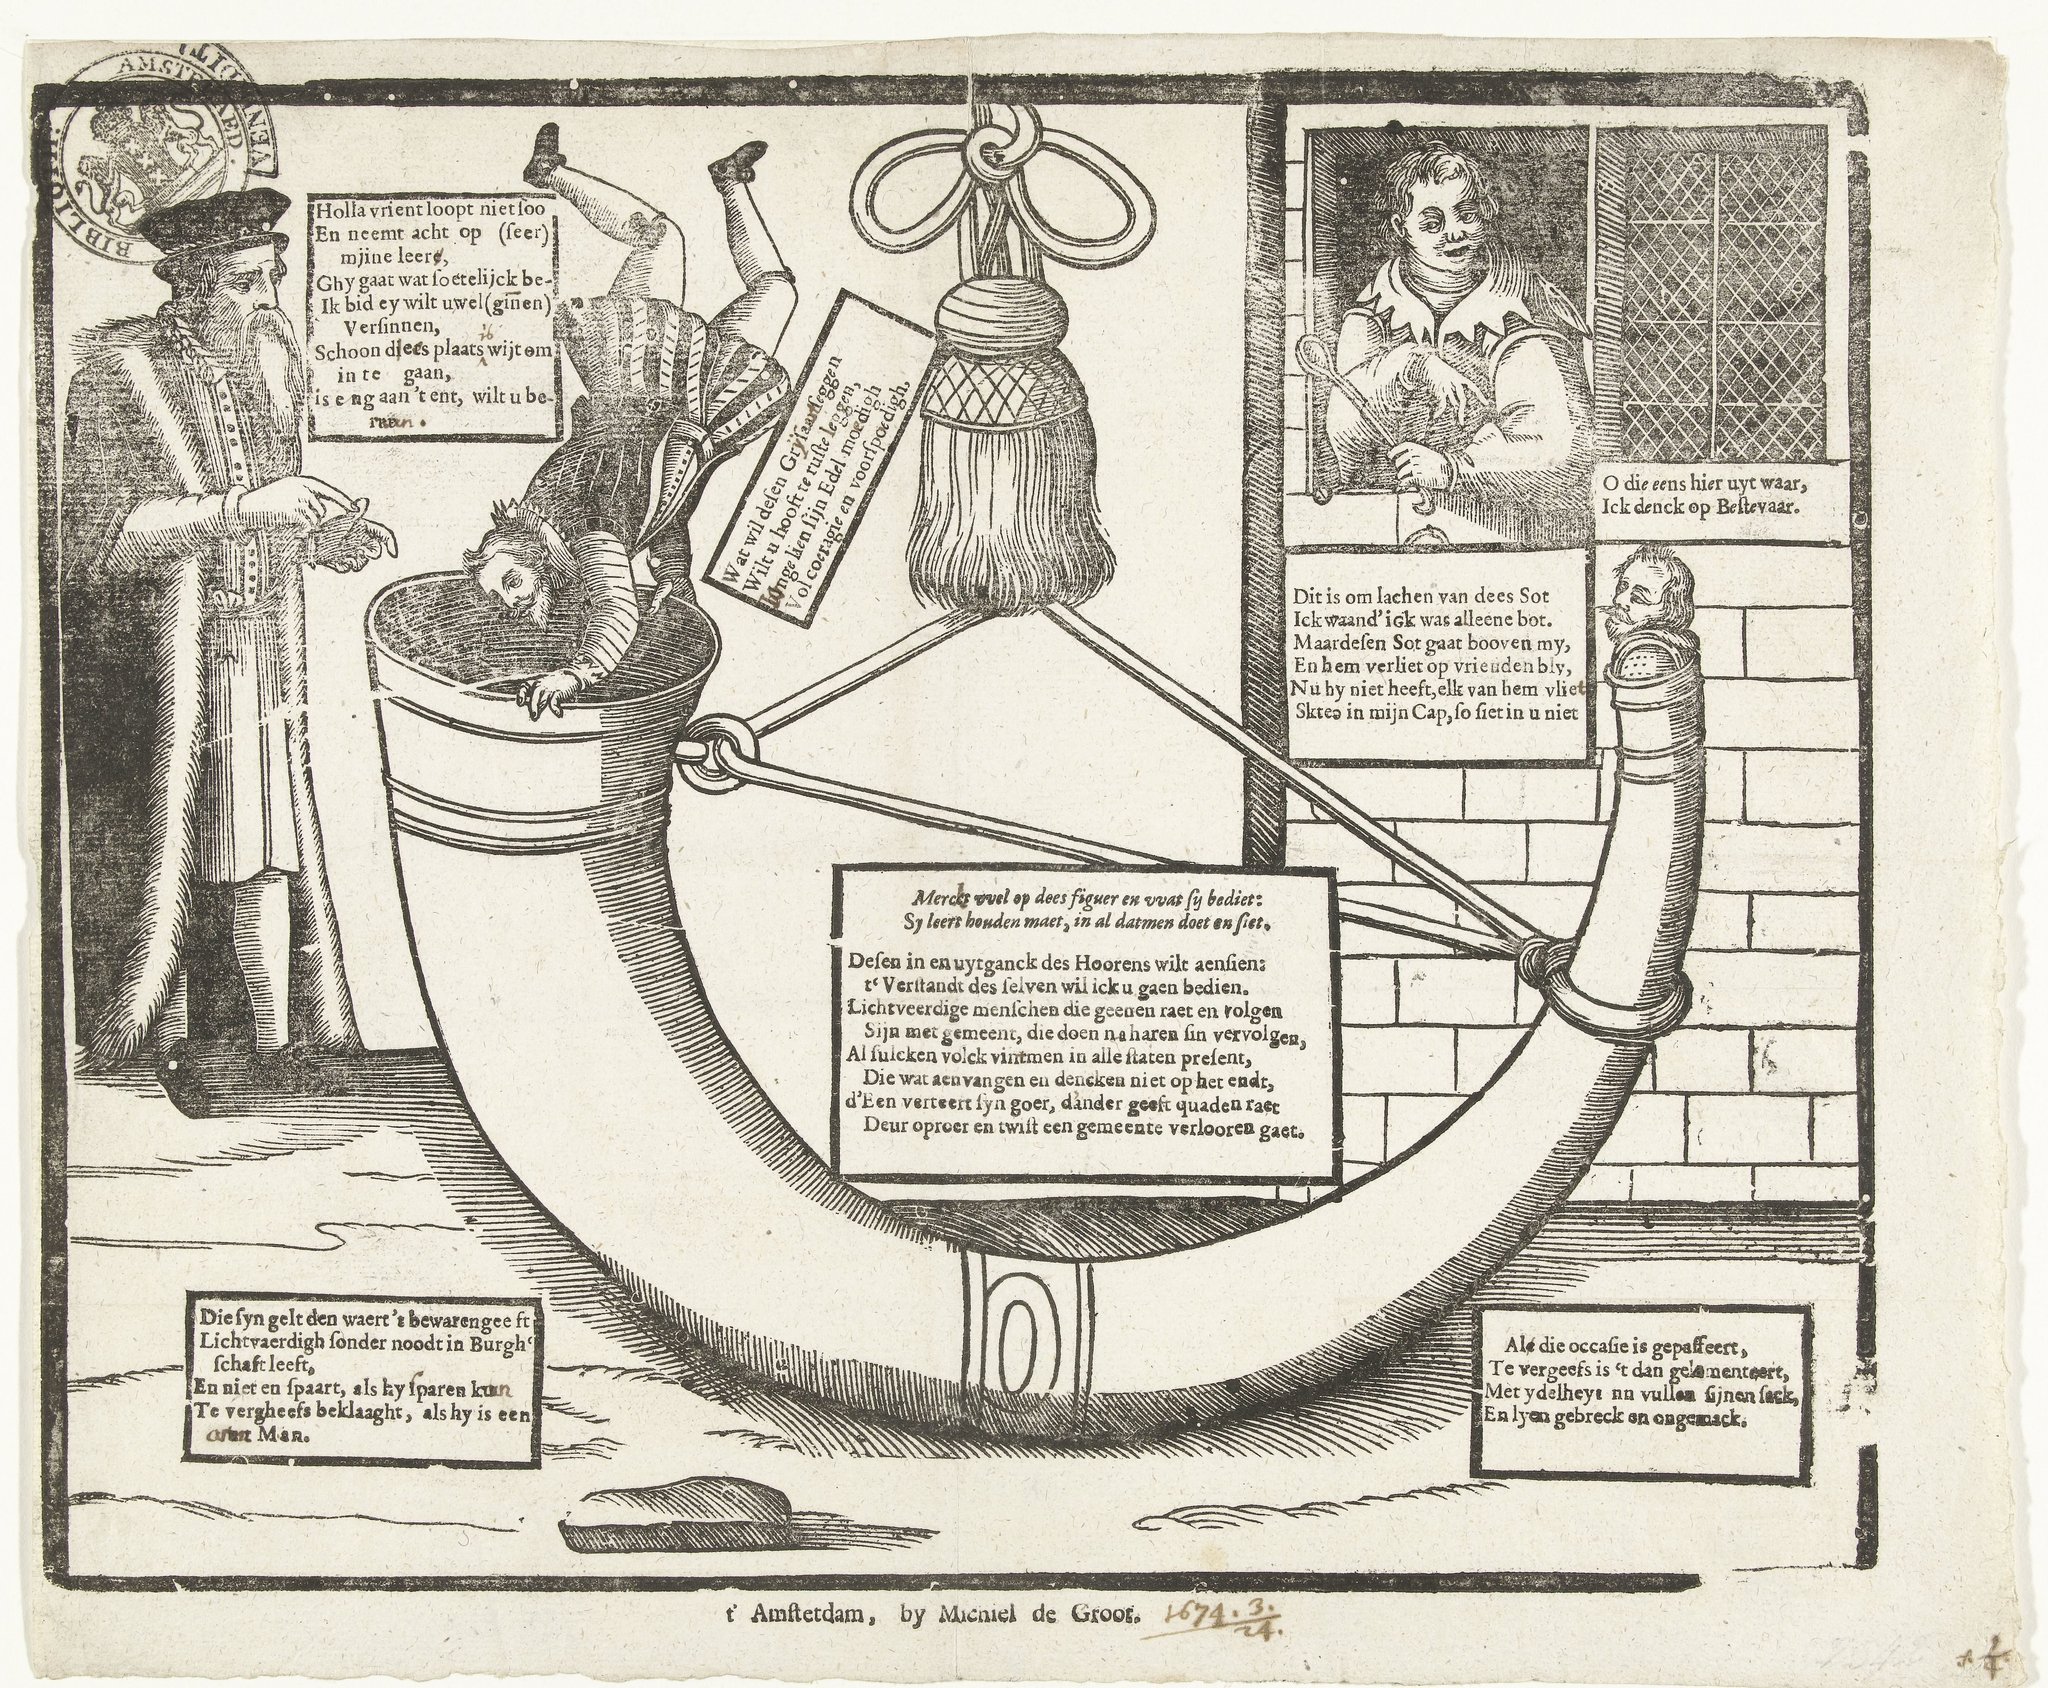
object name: print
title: Mercct wel op dees figuer en wat sy bediet: Sy leert houden maet, in al datmen doet en siet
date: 1575-1599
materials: paper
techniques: letterpress printing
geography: northern netherlands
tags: brussels, paris, earl, court jester, court fool, horn, trumpet, cornet, trombone, tuba, proverbs, sayings, etc., drinking-horn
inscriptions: inscription: ‘1674. 3./24.’, collector's mark: ‘Biblioth. Amstelaed Vendidit’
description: Moralistische voorstelling die weleens wordt geïnterpreteerd als een spotprent op de arminianen of op de graven van Egmond en Hoorne. Door Muller opgenomen als mogelijk een spotprent op de bisschop van Munster of prins Wilhelm von Fürstenberg, op basis van de notitie van de datum 1674 3/24 (24 maart) op de prent. Het opschrift in het midden 'Sy leert houden maet, in al datmen doet en siet' duidt het onderwerp van de voorstelling beter aan. Het onderwerp kan ook worden verwoord als: 'Bezint eer ge begint' of 'Hij werkt zich in het nauw'. Ondanks de waarschuwingen van een oude man duikt een jongeman in de wijde opening van een grote hoorn. Vervolgens komt hij echter in het smalle uiteinde klem te zitten. Rechts kijkt een lachende nar uit het raam. Zie ook de interpretatie van de 'hoornkruiper'. Met zeven versjes in de voorstelling.